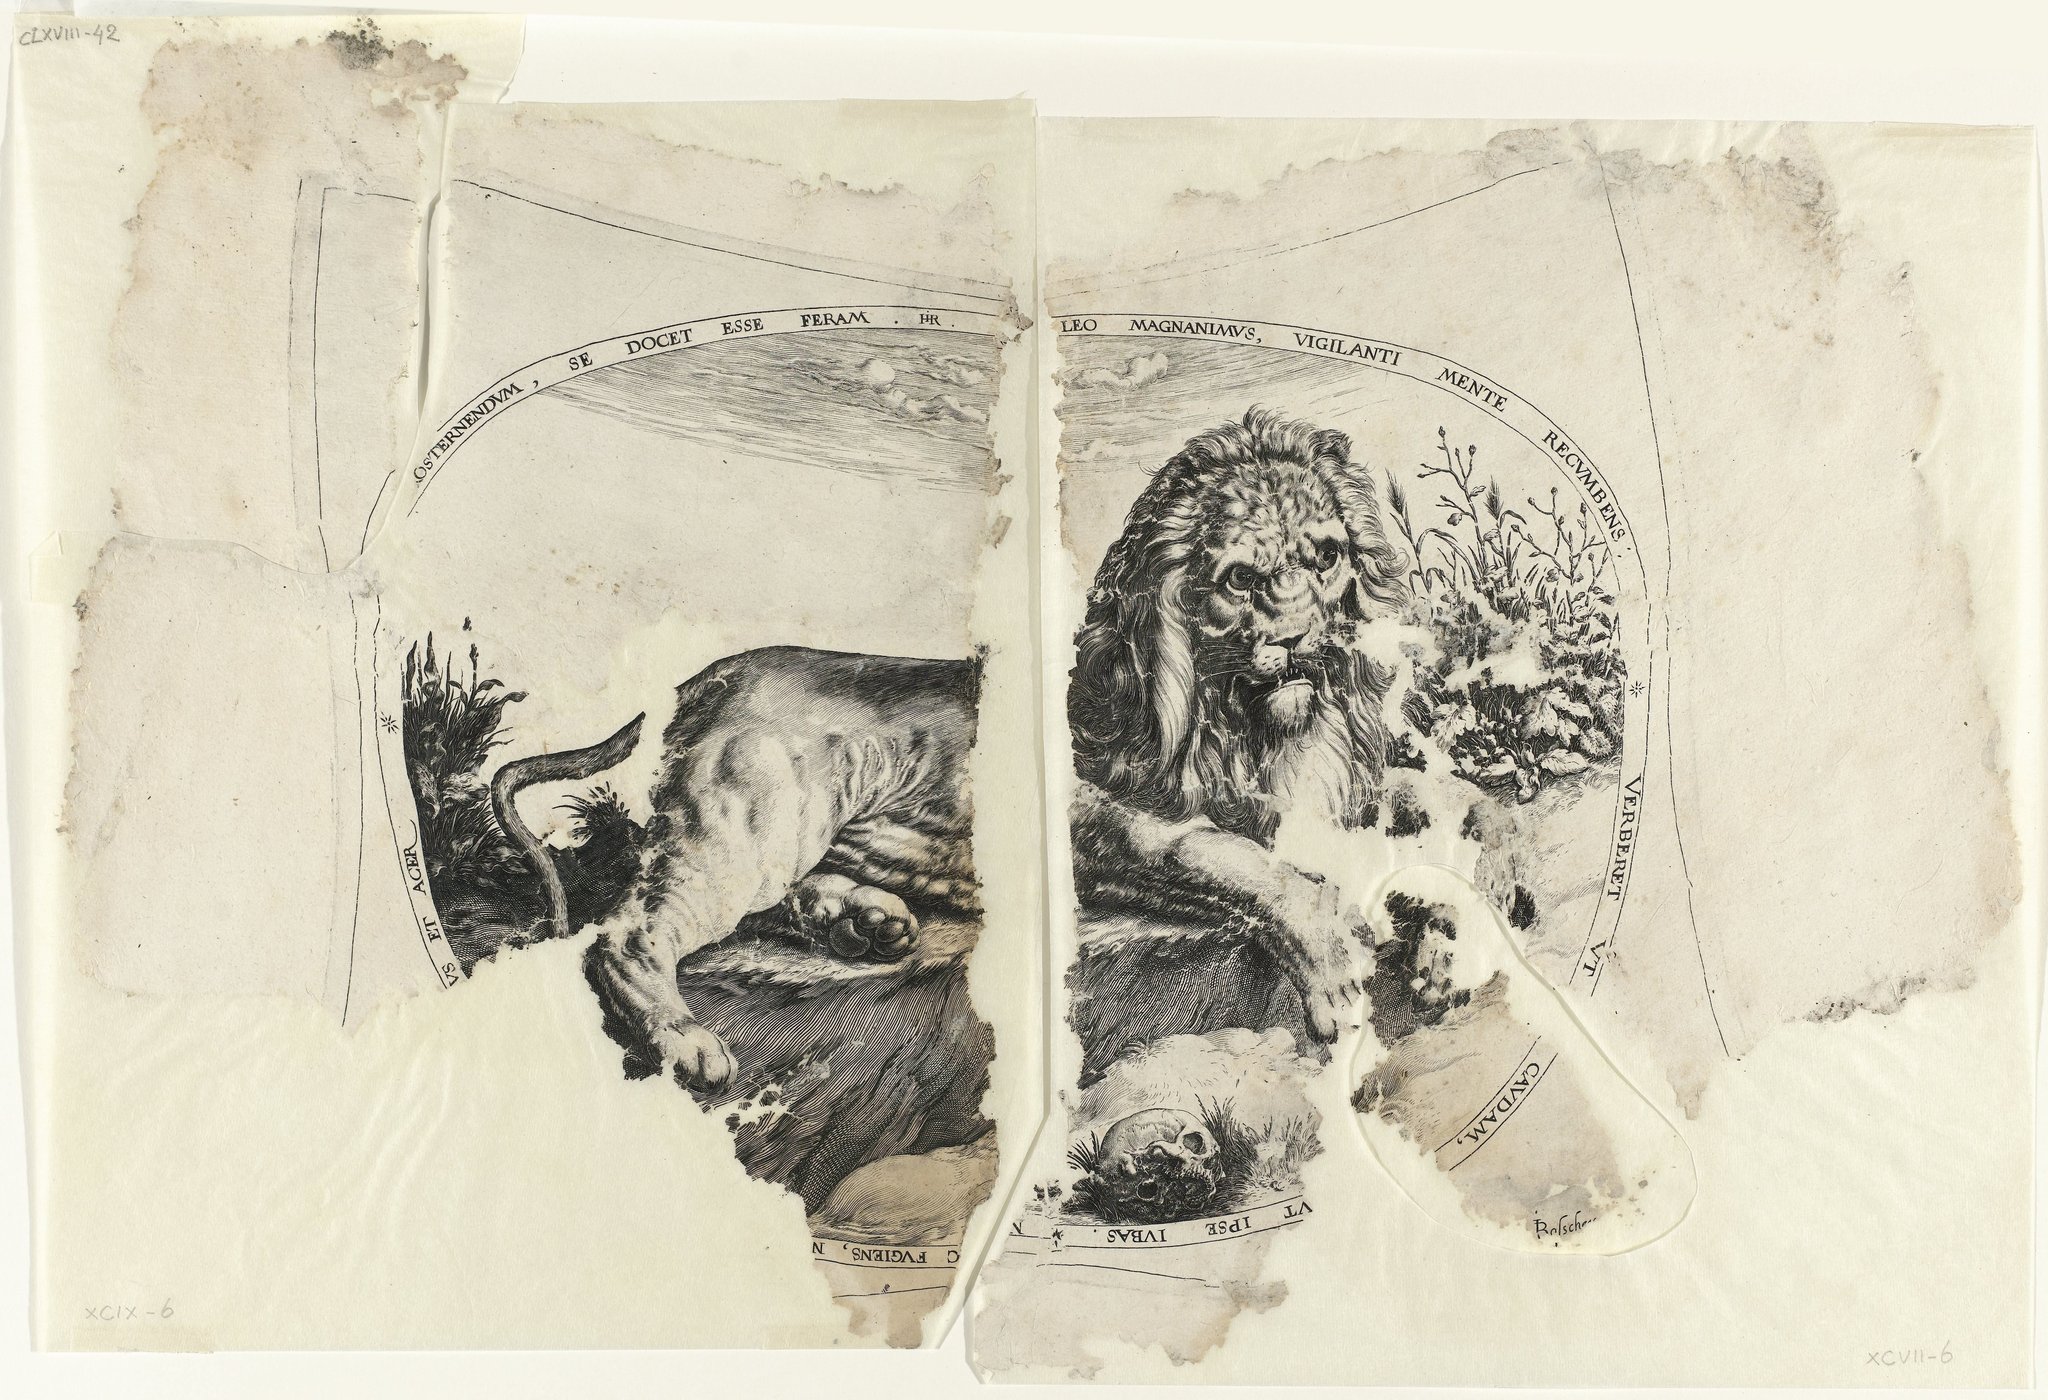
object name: print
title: Leeuw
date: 1580-1596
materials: paper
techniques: engraving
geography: northern netherlands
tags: beasts of prey, predatory animals: lion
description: De prenten in de Nova Zembla collectie zijn tijdens een expeditie van Willem Barendsz en Jacob van Heemskerk in 1596-1597 noodgedwongen in het winterkamp, het ‘Behouden Huis’, op het eiland achtergelaten. De prenten waren in één of meerdere stapels als handelswaar meegenomen vanuit Amsterdam. Bijna drie eeuwen later, in 1871, keerde de Noor Elling Carlsen terug naar Nova Zembla en vond daar de restanten van het ‘Behouden Huis, inclusief een groot deel van de inventaris. Een deel van de prenten, in de vorm van aaneengekoekte kluiten, werd toen ook teruggevonden. De papierkluiten waren soms op meerdere plekken gebroken. Tussen 1975-1979 zijn de prenten van elkaar gescheiden. Dit leverde in totaal ca. 1000 fragmenten van ca. 400 afdrukken van ca. 150 verschillende prenten op. Voor zover mogelijk zijn de fragmenten samengevoegd en zijn de prenten gereconstrueerd.